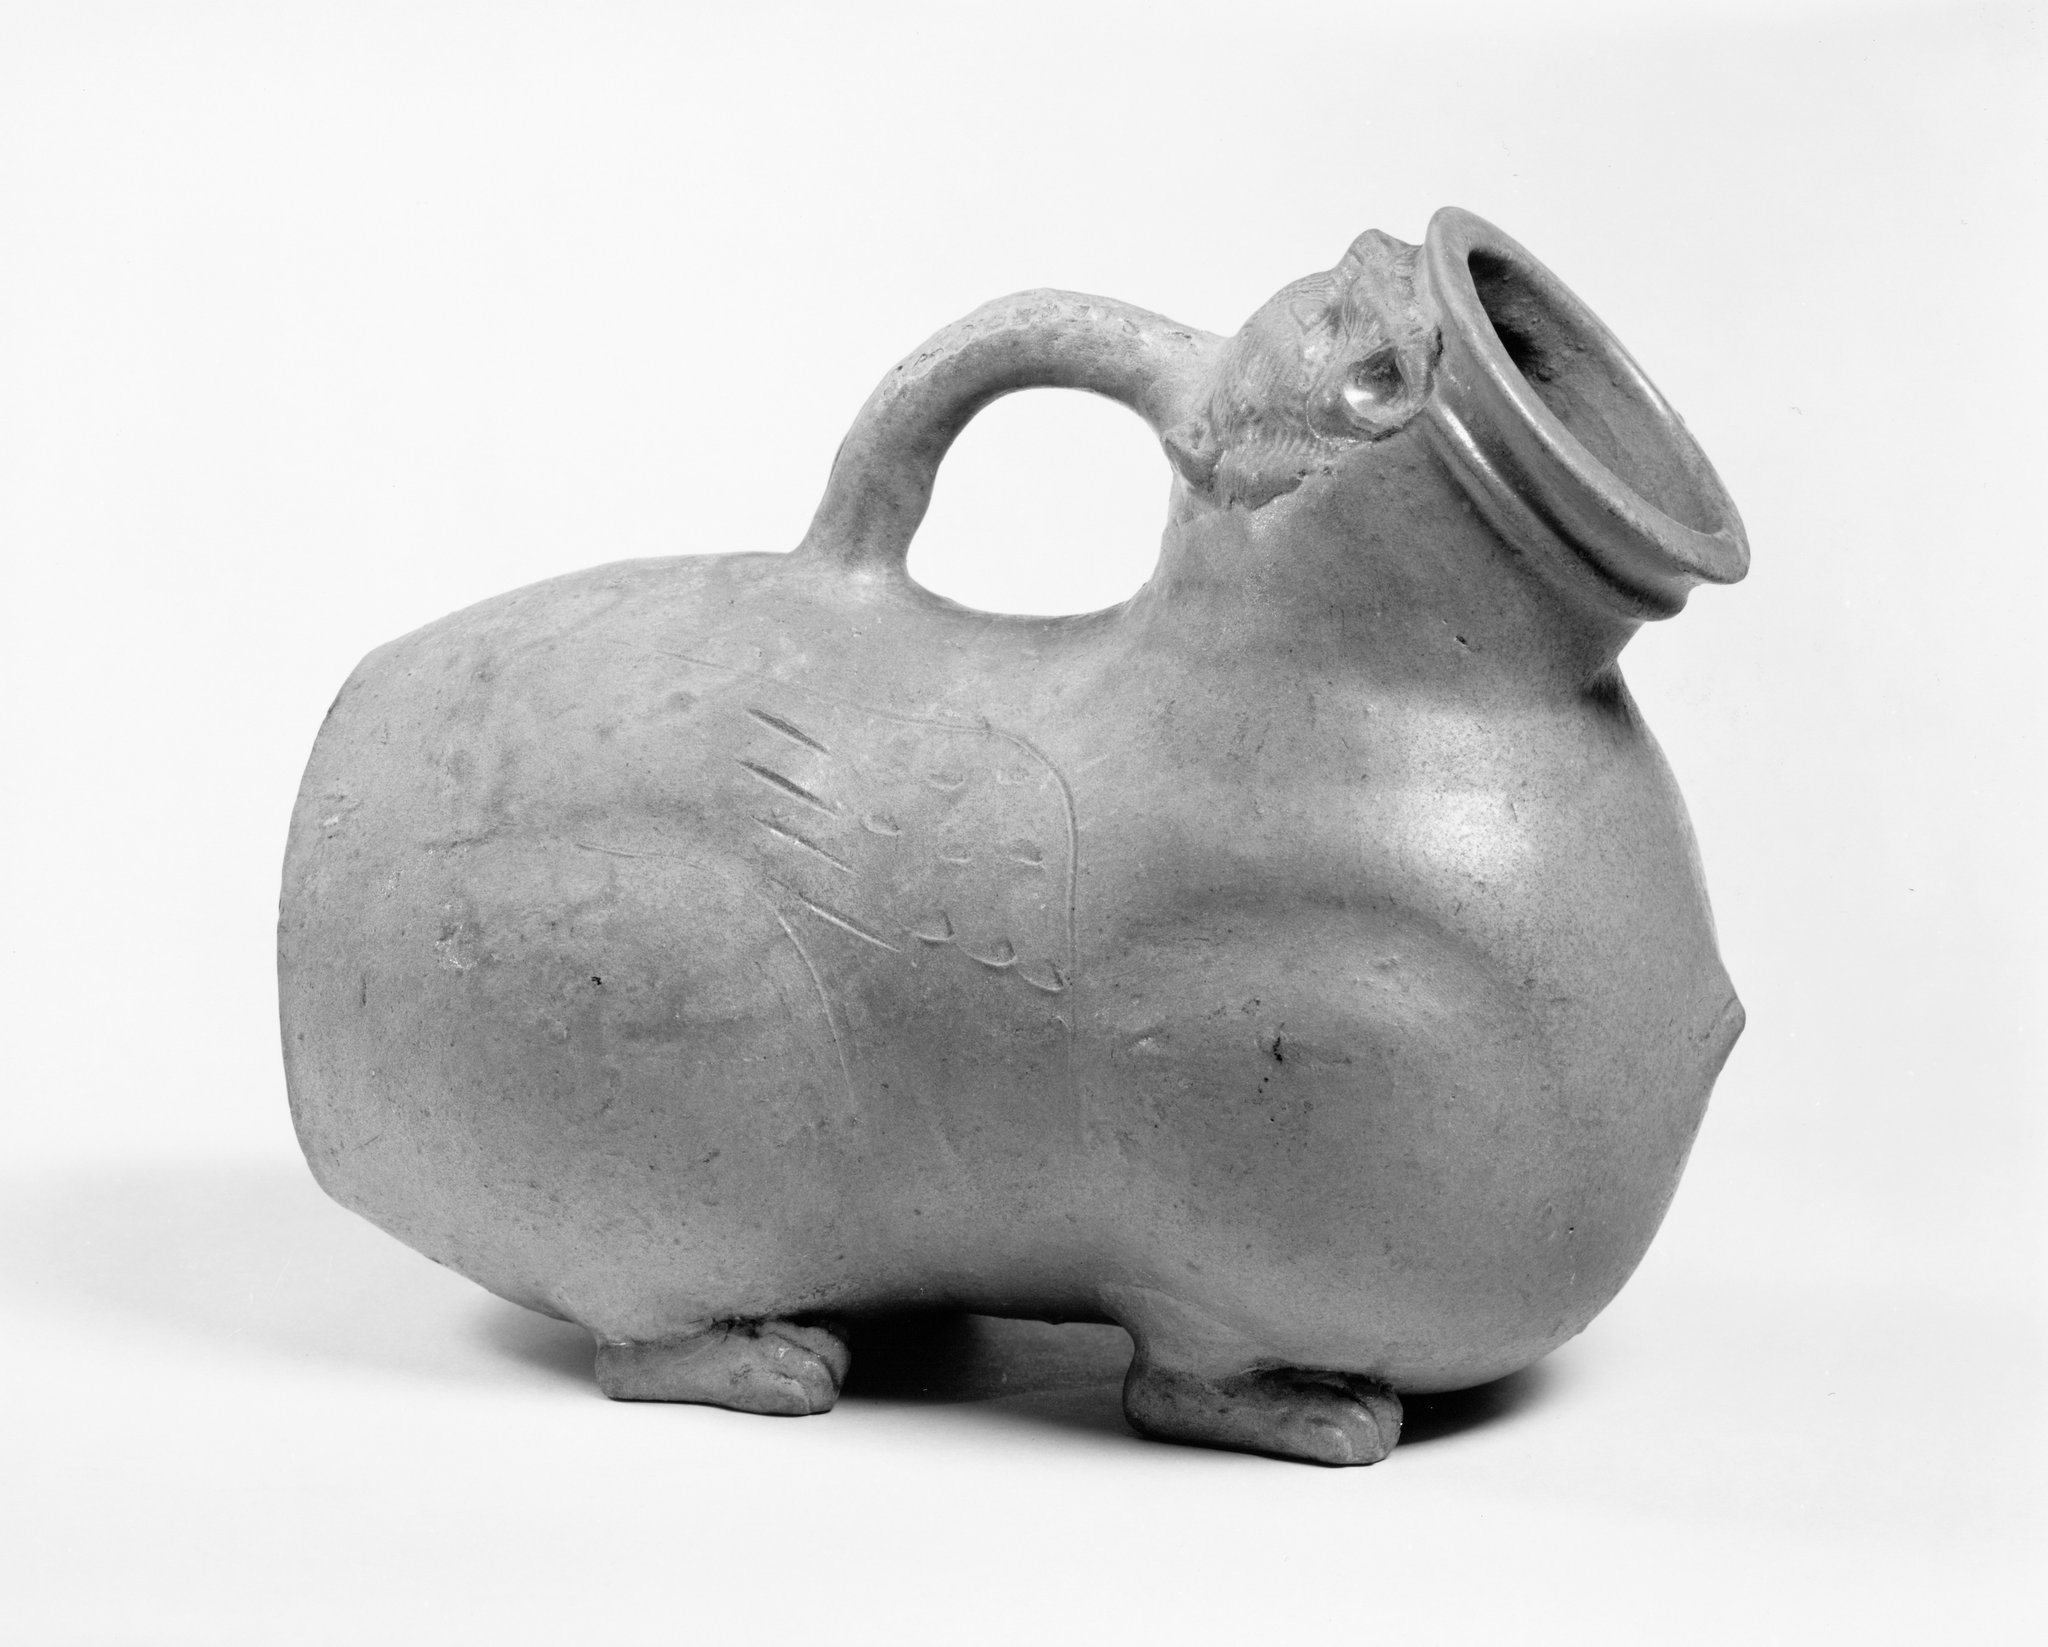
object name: vessel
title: Vessel in the Shape of a Tiger (Huzi)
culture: chinese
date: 301-400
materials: glaze, porcelain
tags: animals